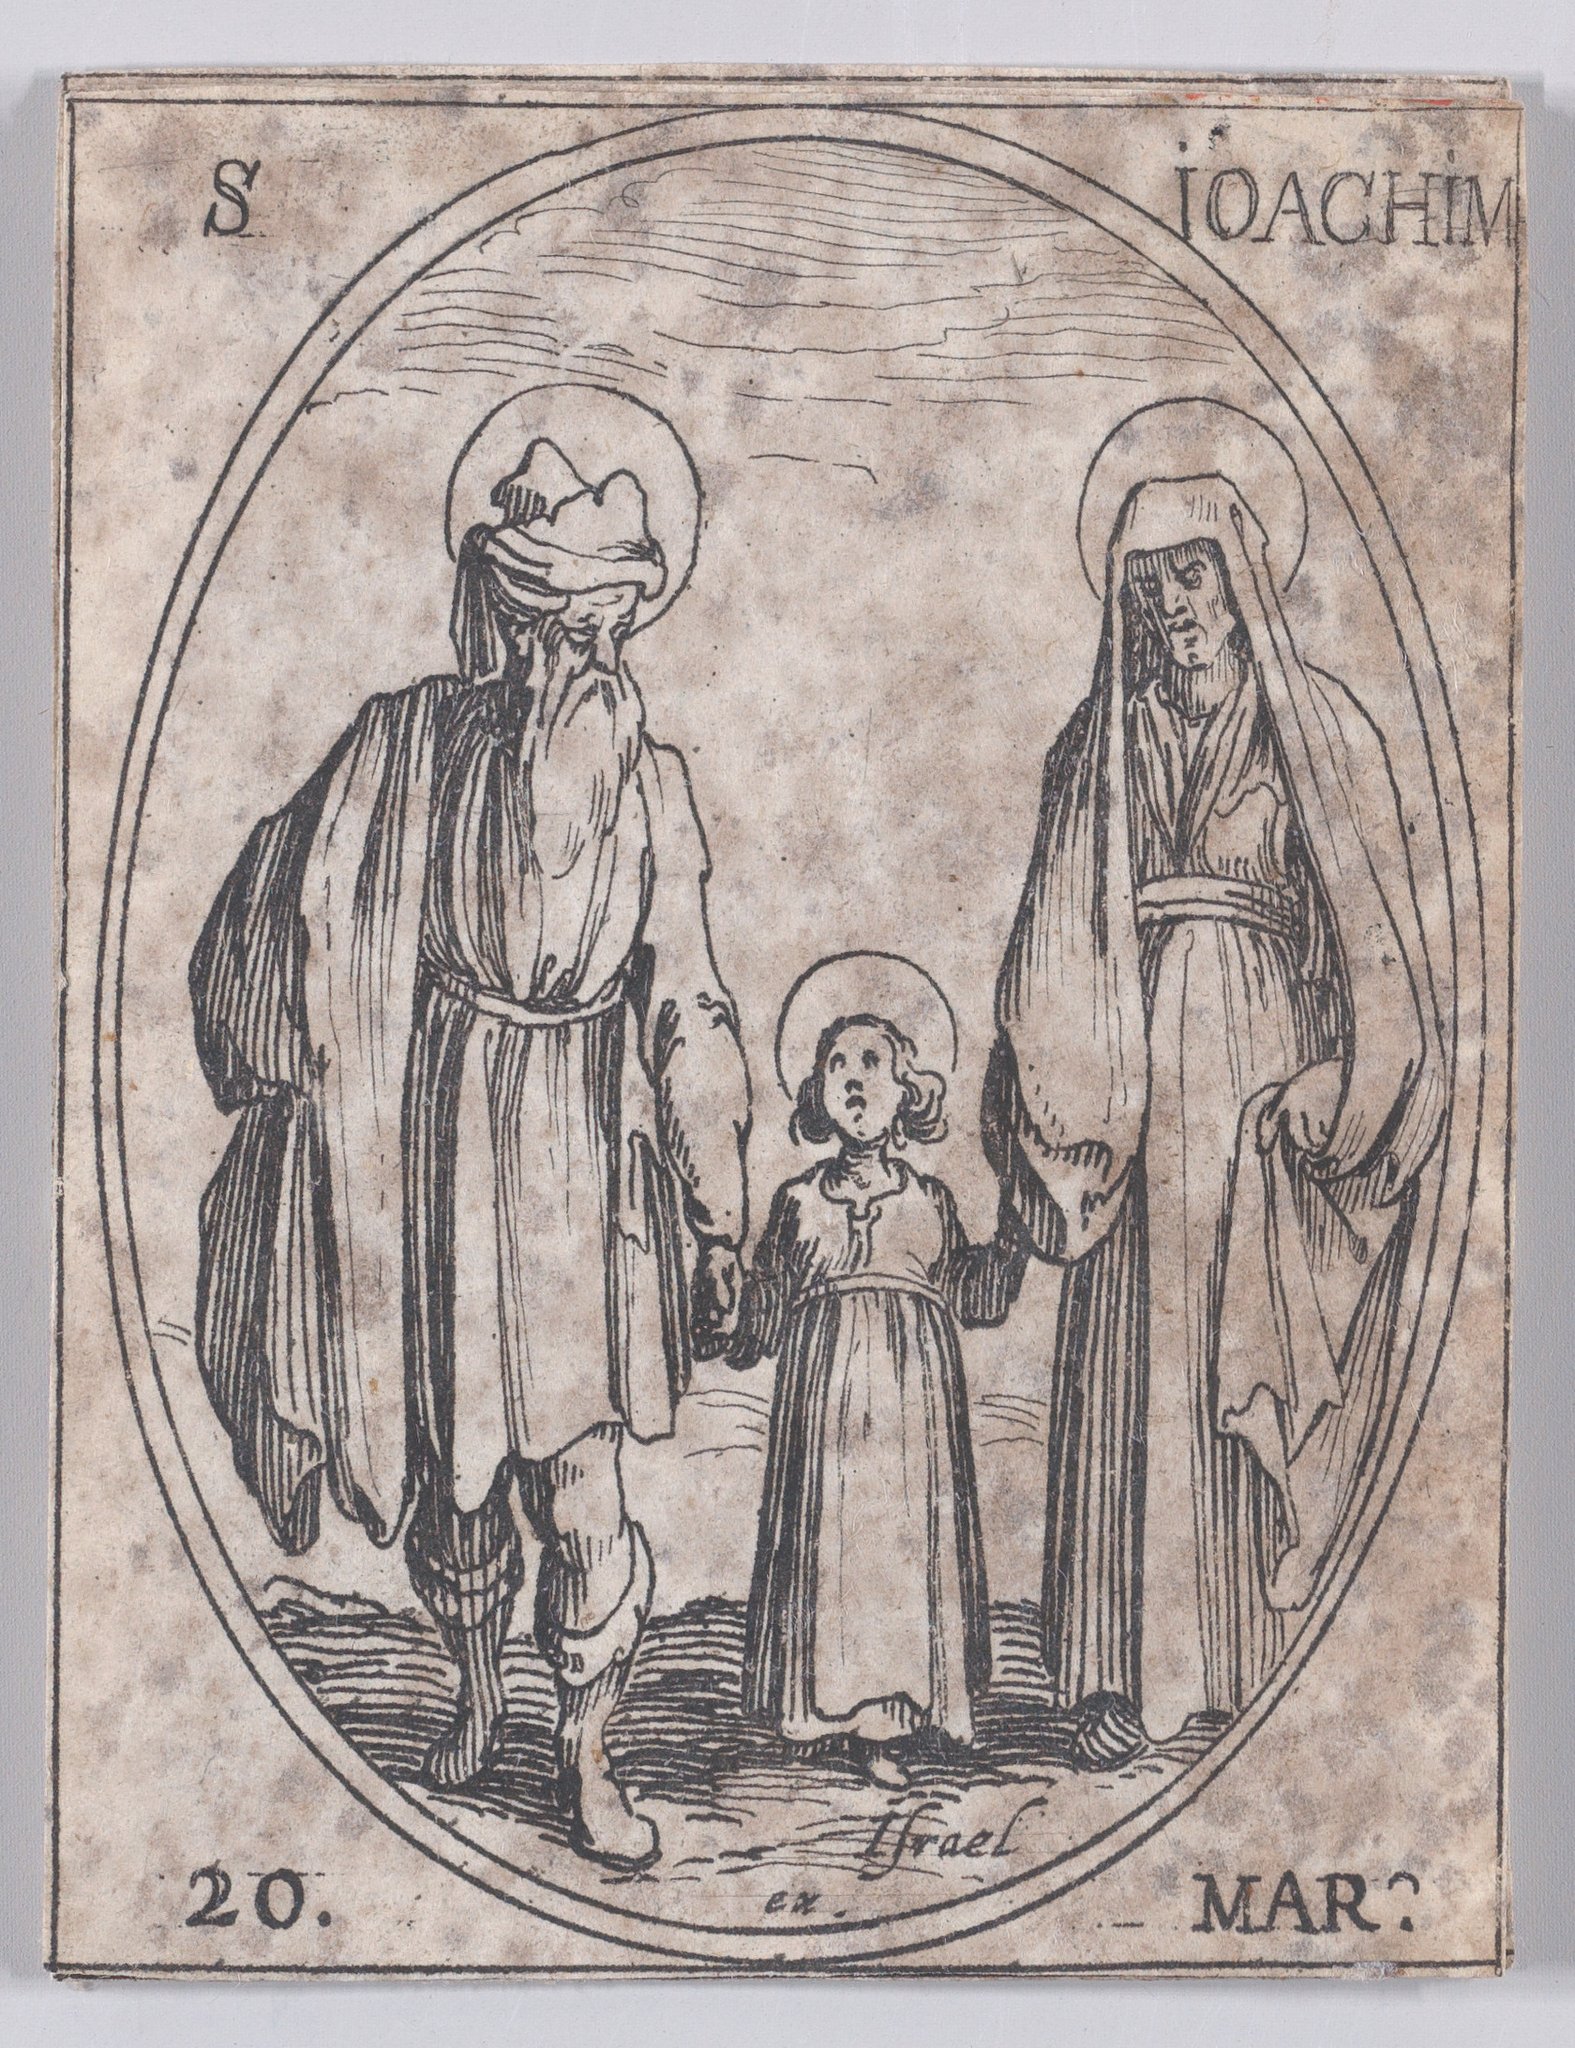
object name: print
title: St. Joachim, March 20th, from "Les Images De Tous Les Saincts et Saintes de L'Année" (Images of All of the Saints and Religious Events of the Year)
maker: jacques callot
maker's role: artist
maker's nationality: french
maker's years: 1592-1635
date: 1636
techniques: etching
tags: men,saints